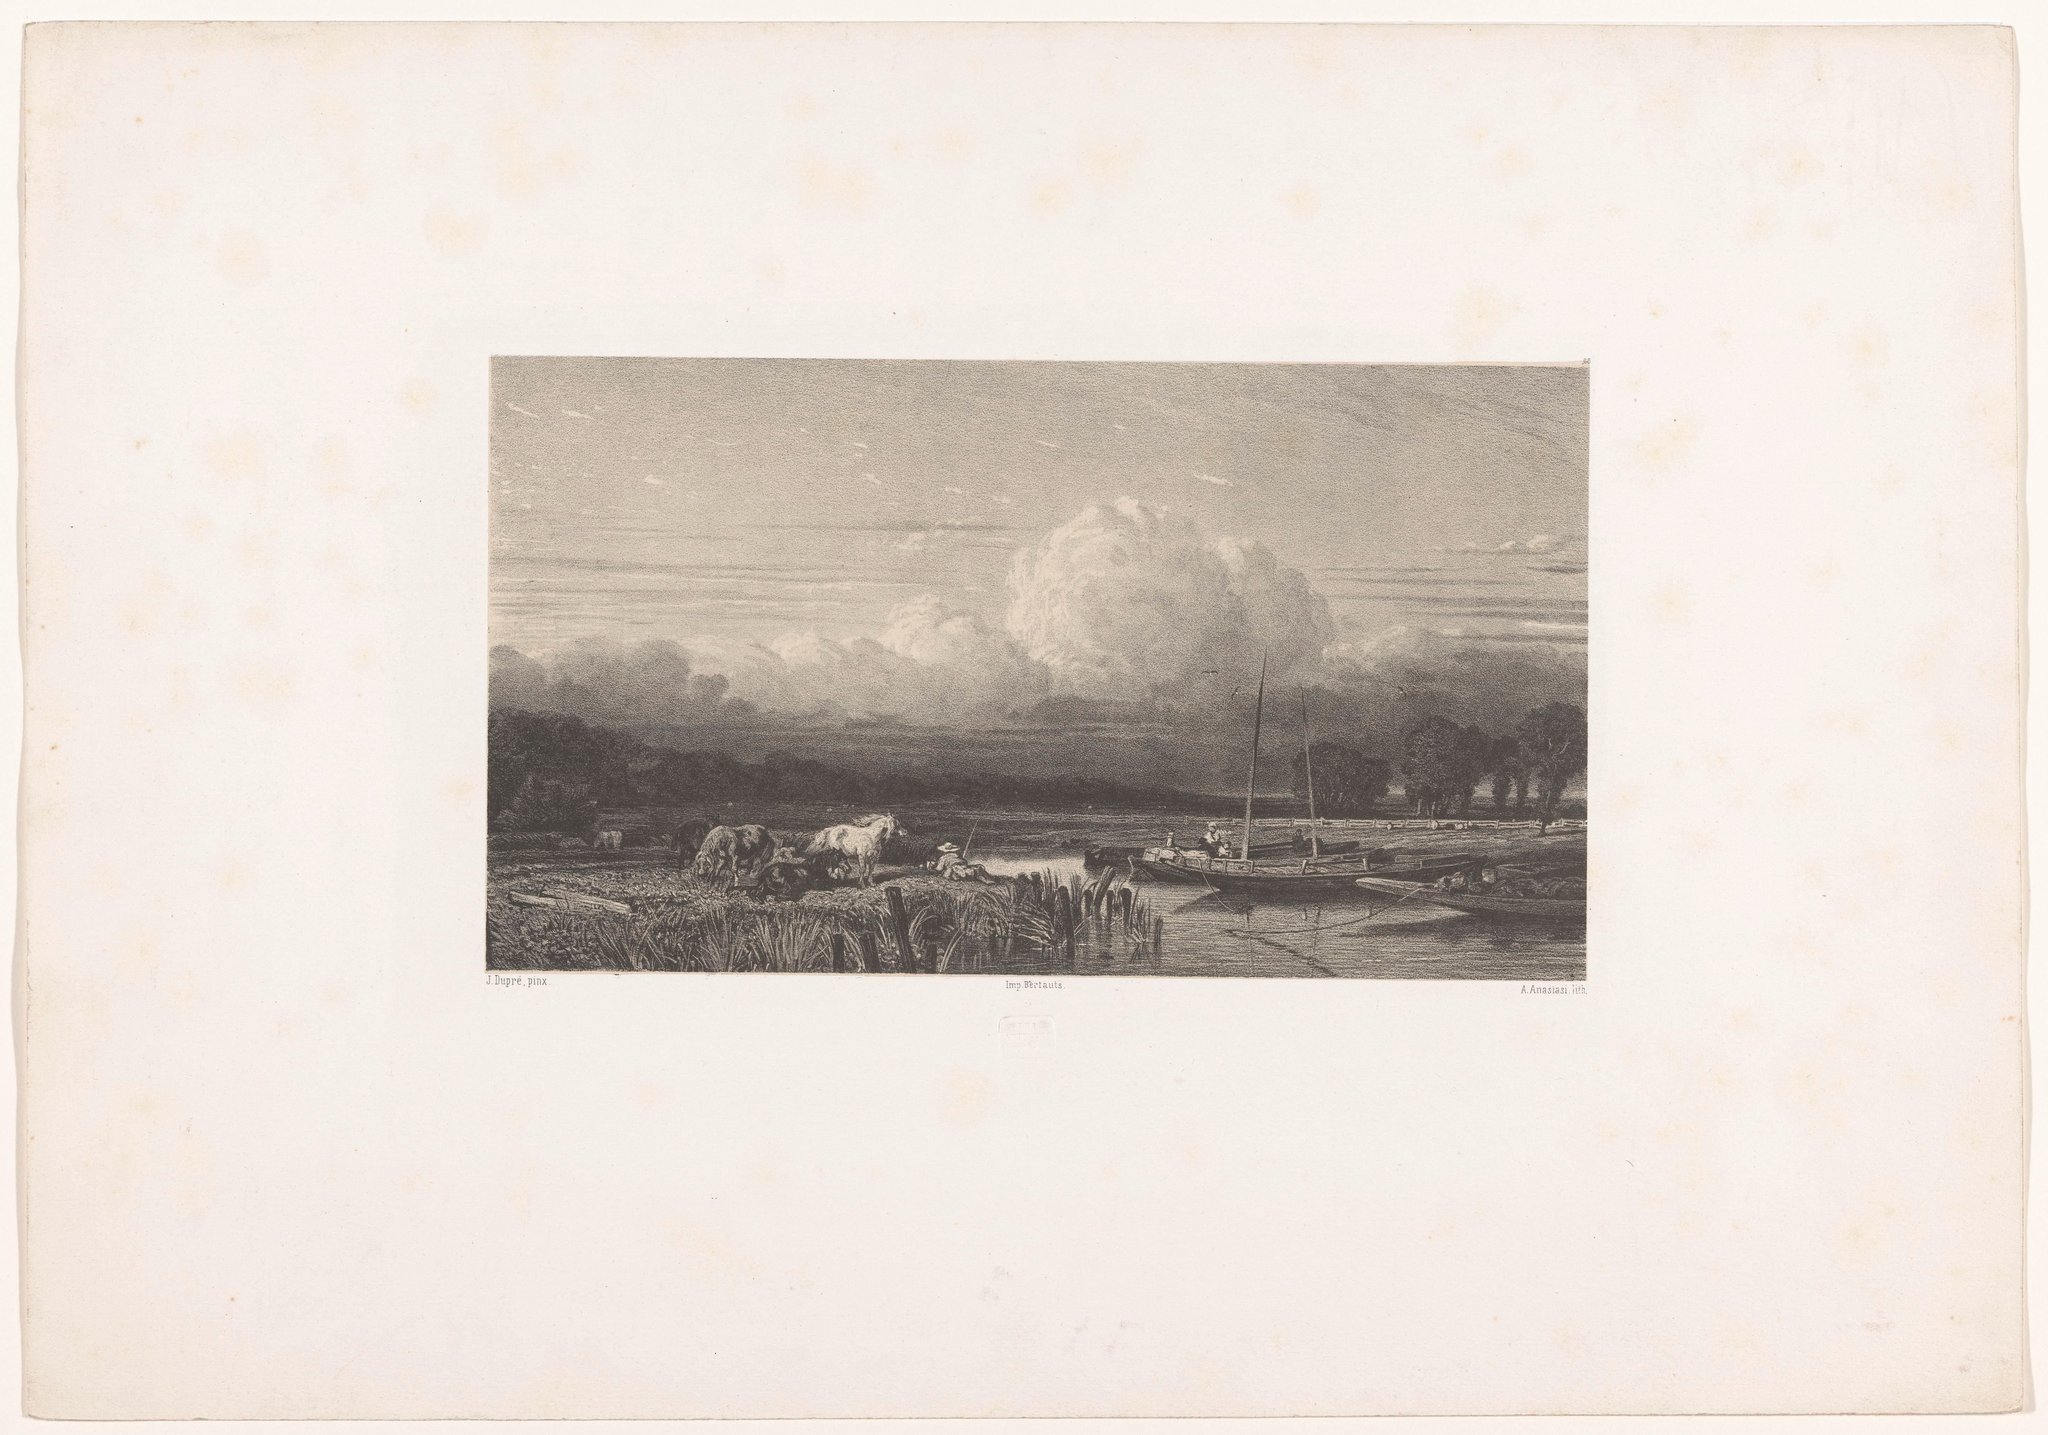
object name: print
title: Les artistes contemporains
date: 1848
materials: paper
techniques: tone lithography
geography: paris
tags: river, river bank, horse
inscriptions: collector's mark: Lugt 2228, check stamp: Lugt 36b